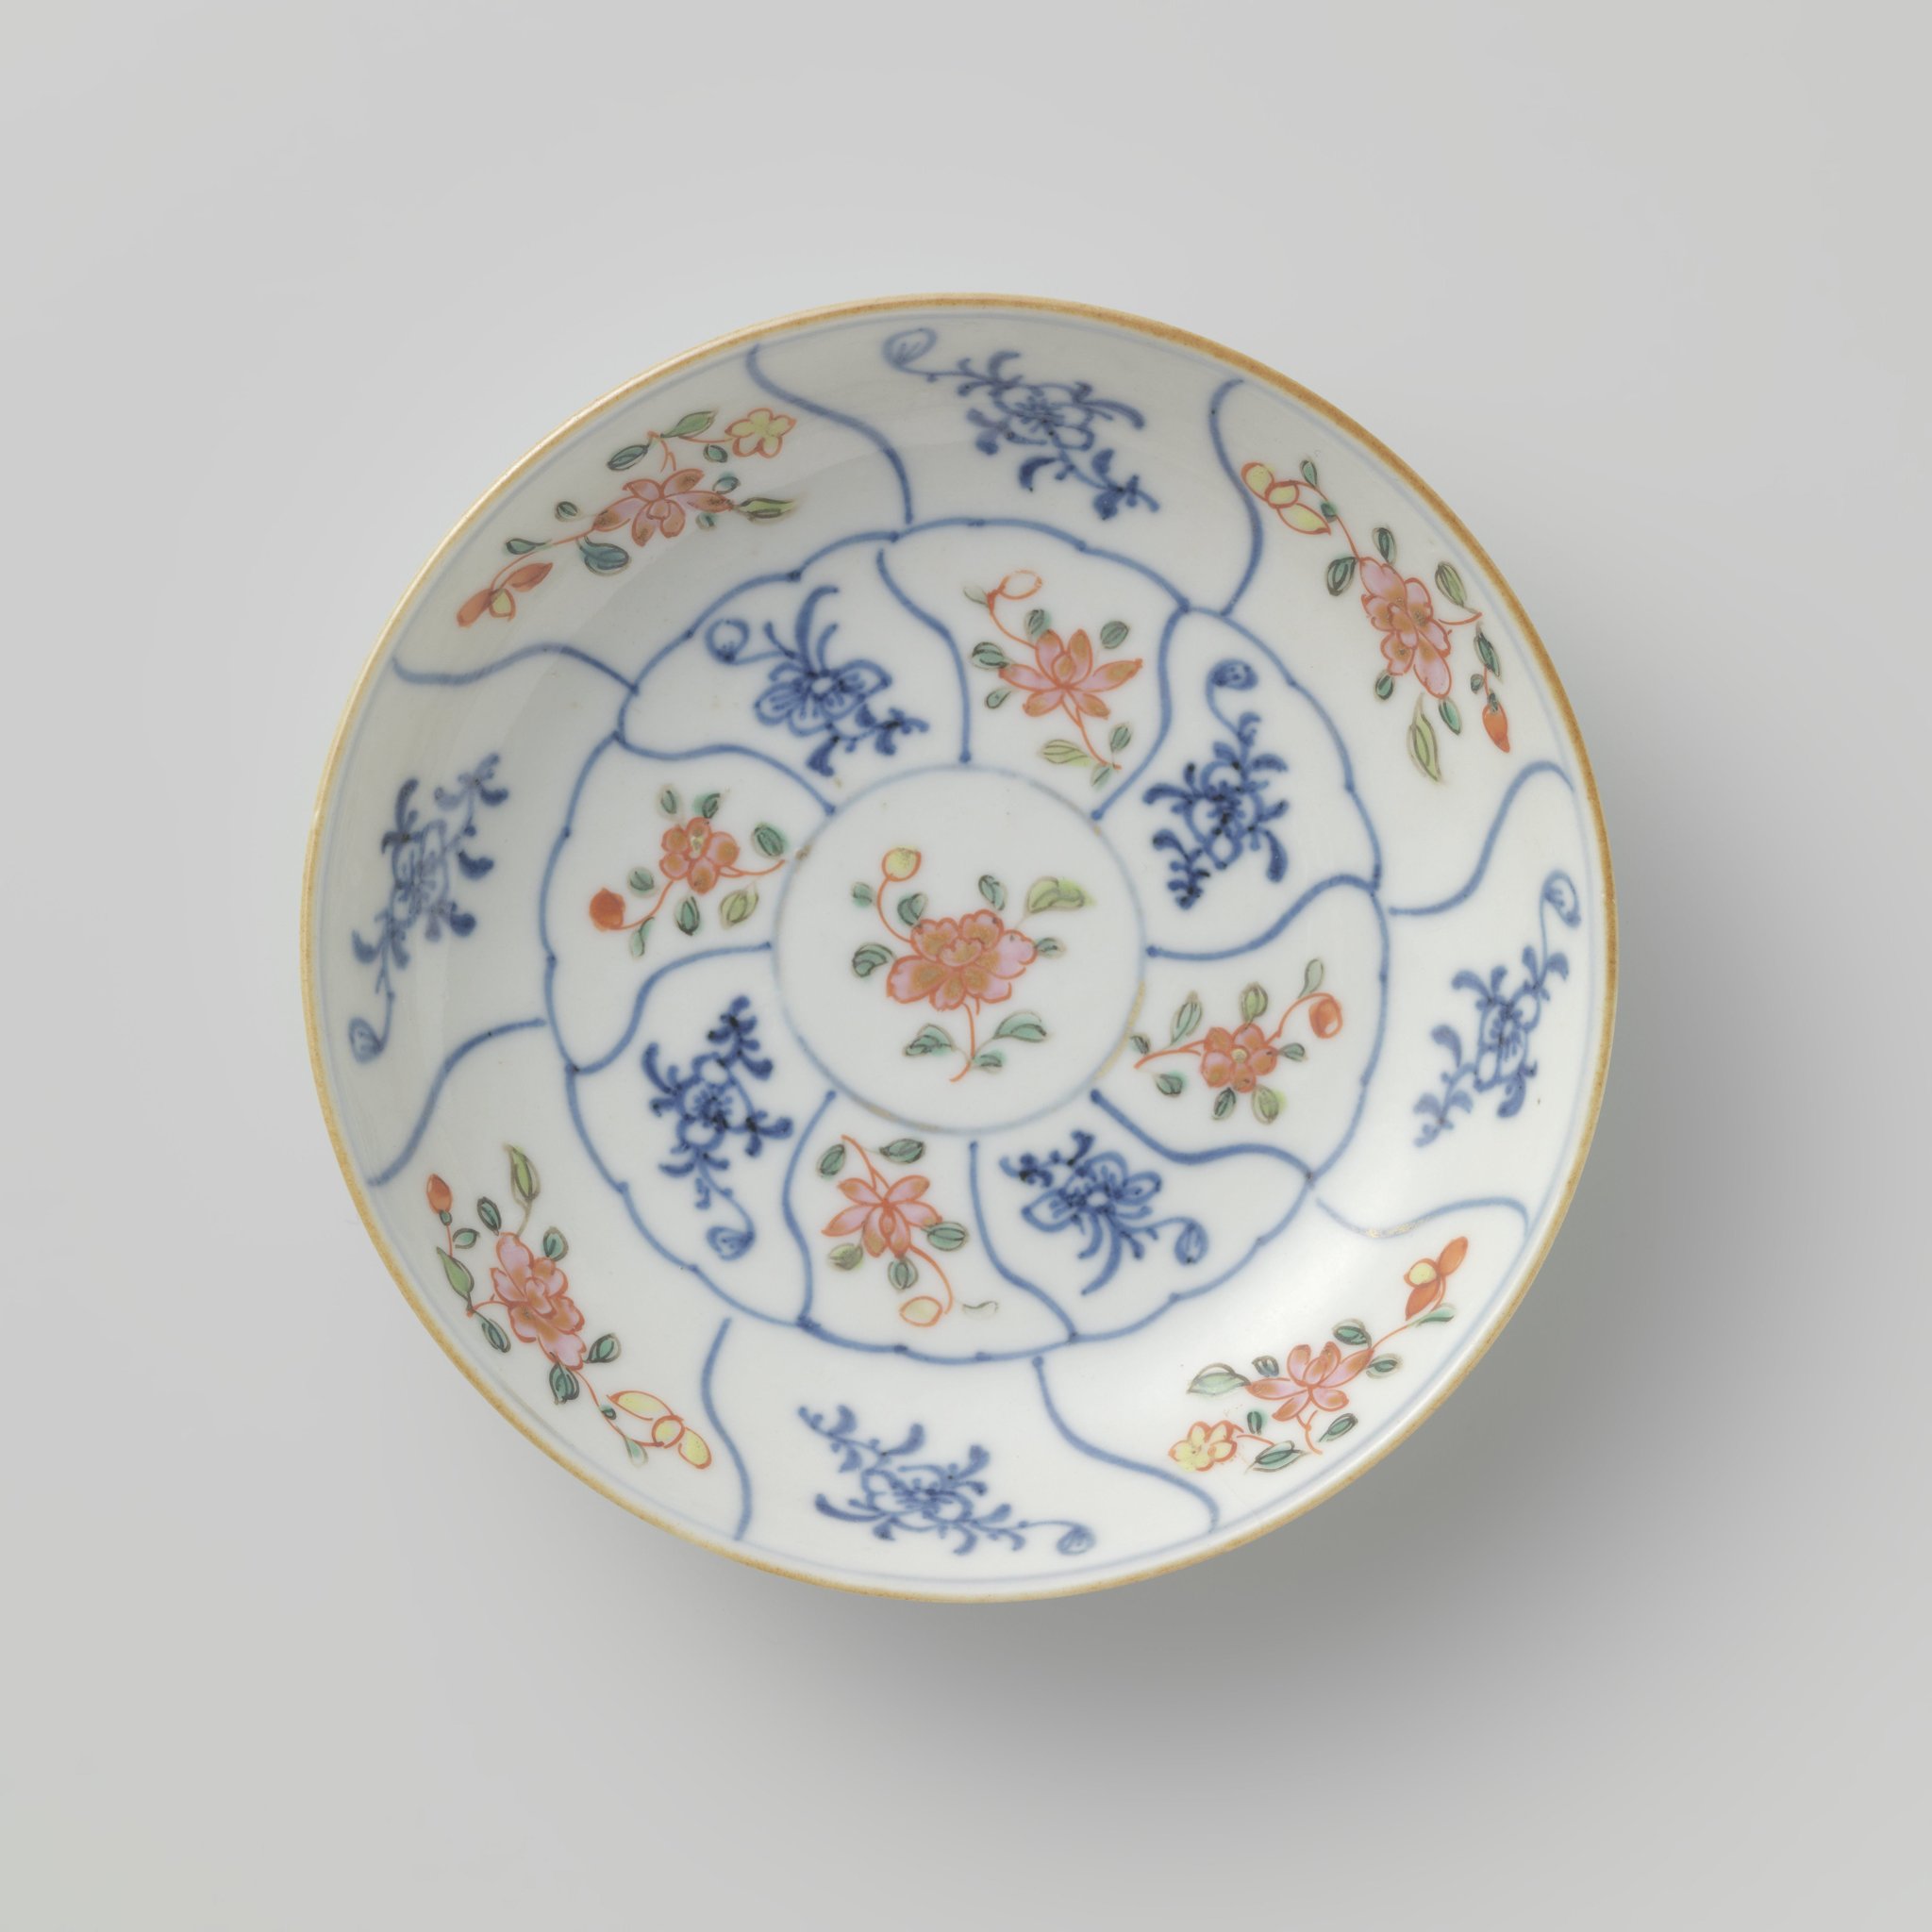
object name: platter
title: Saucer with petal-shaped panels with flower sprays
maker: Anonymous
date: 1750-1774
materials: cobalt, glaze, gold, paint, porcelain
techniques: firing, gilding, turning, vitrification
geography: china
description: Schotel van porselein met rechte wand, beschilderd in onderglazuur blauw en op het glazuur rood, roze, groen, geel, zwart en goud. Op het plat van de schotel een medaillon met bloemtak; hier omheen twee rijen met bloemtakken in bloembladvormige vakken. Famille rose.